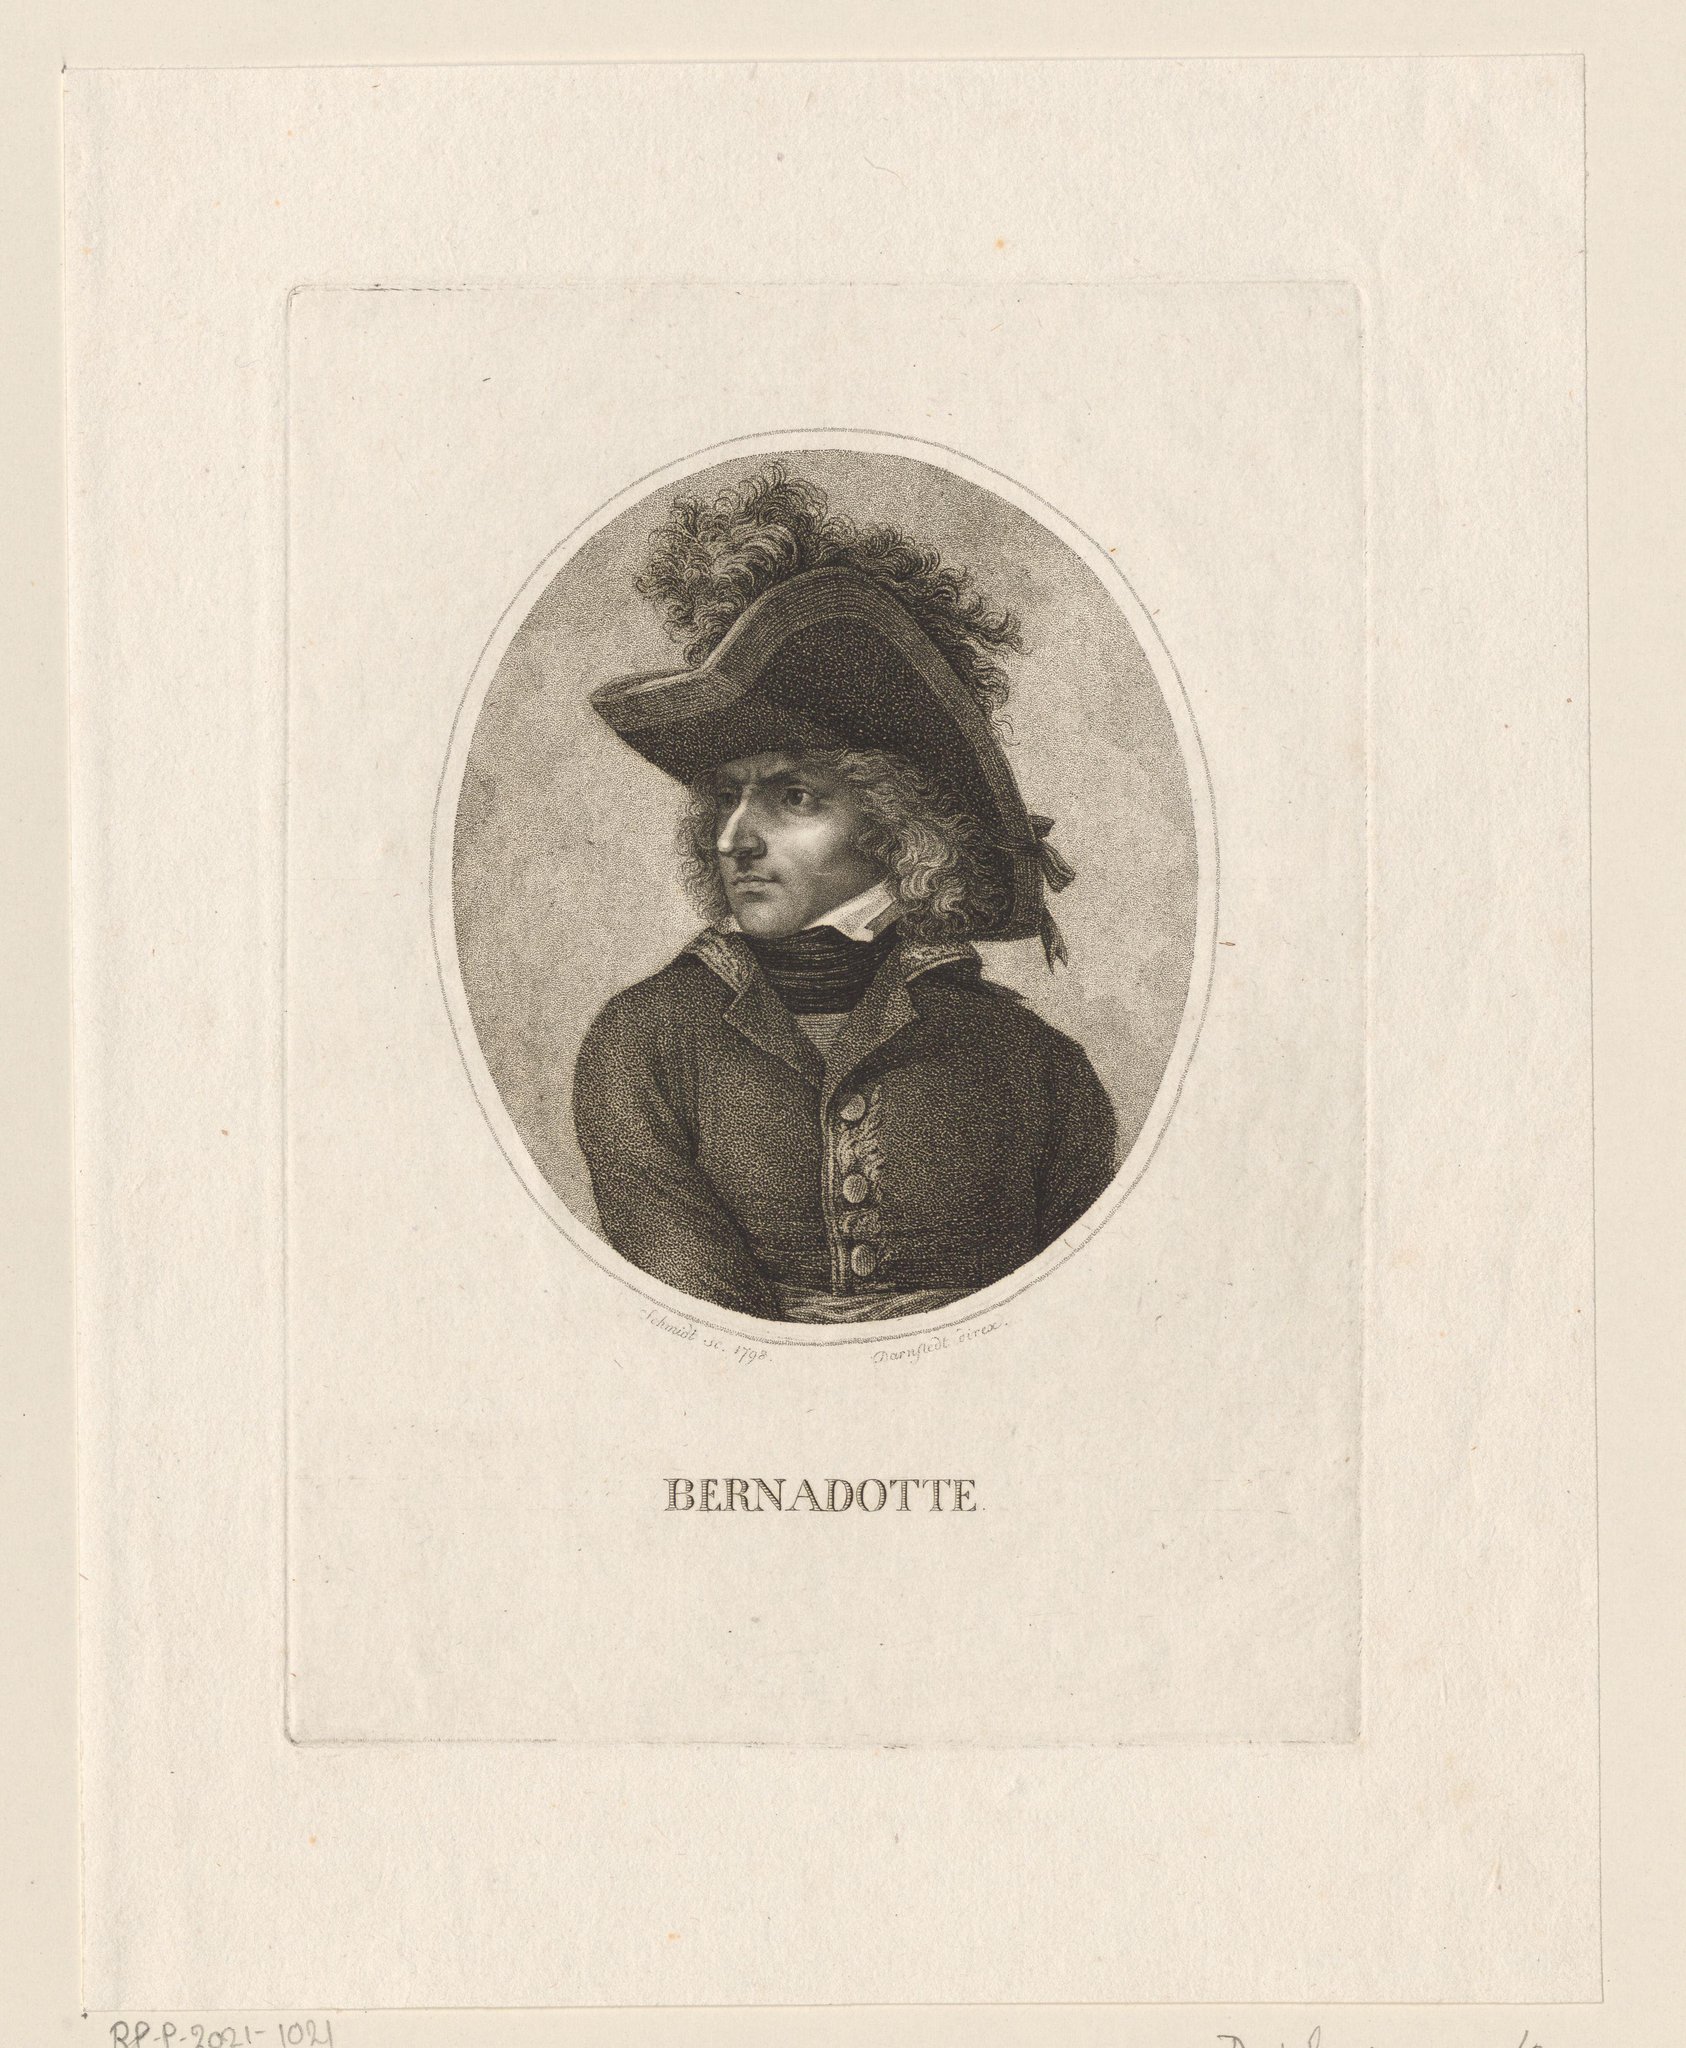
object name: print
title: Portret van Jean-Baptiste Jules Bernadotte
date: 1798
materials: paper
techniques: engraving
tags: commander-in-chief, general, marshal, historical persons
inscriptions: date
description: Portret van Jean-Baptiste Jules Bernadotte, de latere Karel XIV Johan, koning van Zweden en Noorwegen.